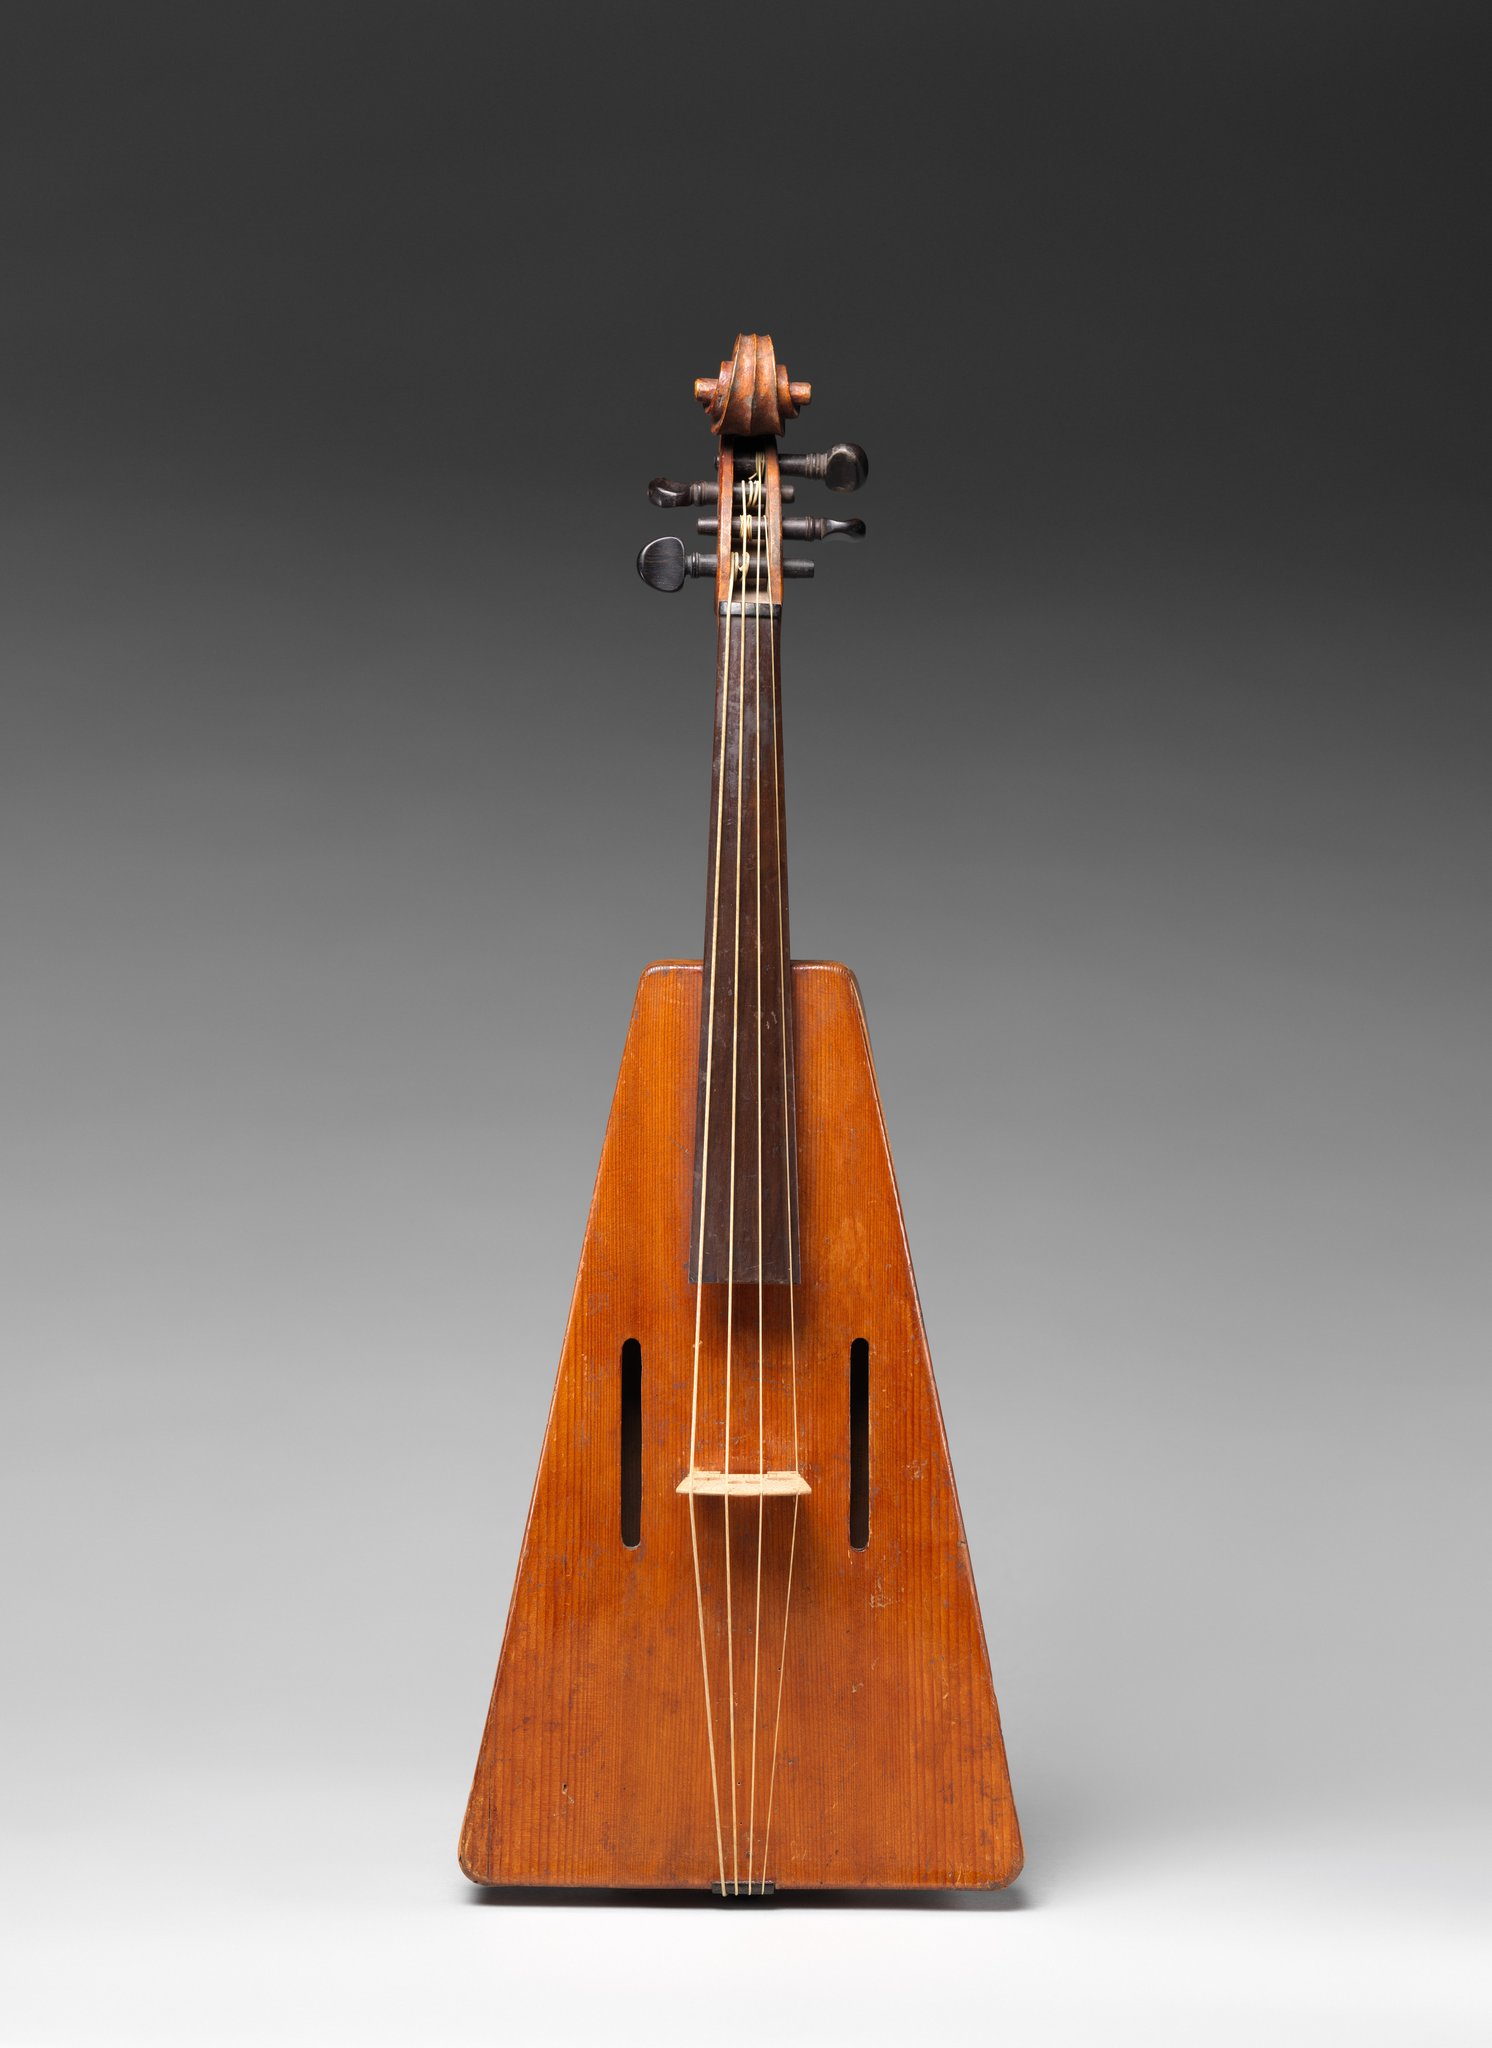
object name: savart model violin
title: "Savart model" Violin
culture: french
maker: ch. michel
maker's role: maker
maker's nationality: french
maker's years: 1800-1900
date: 1819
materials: wood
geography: france